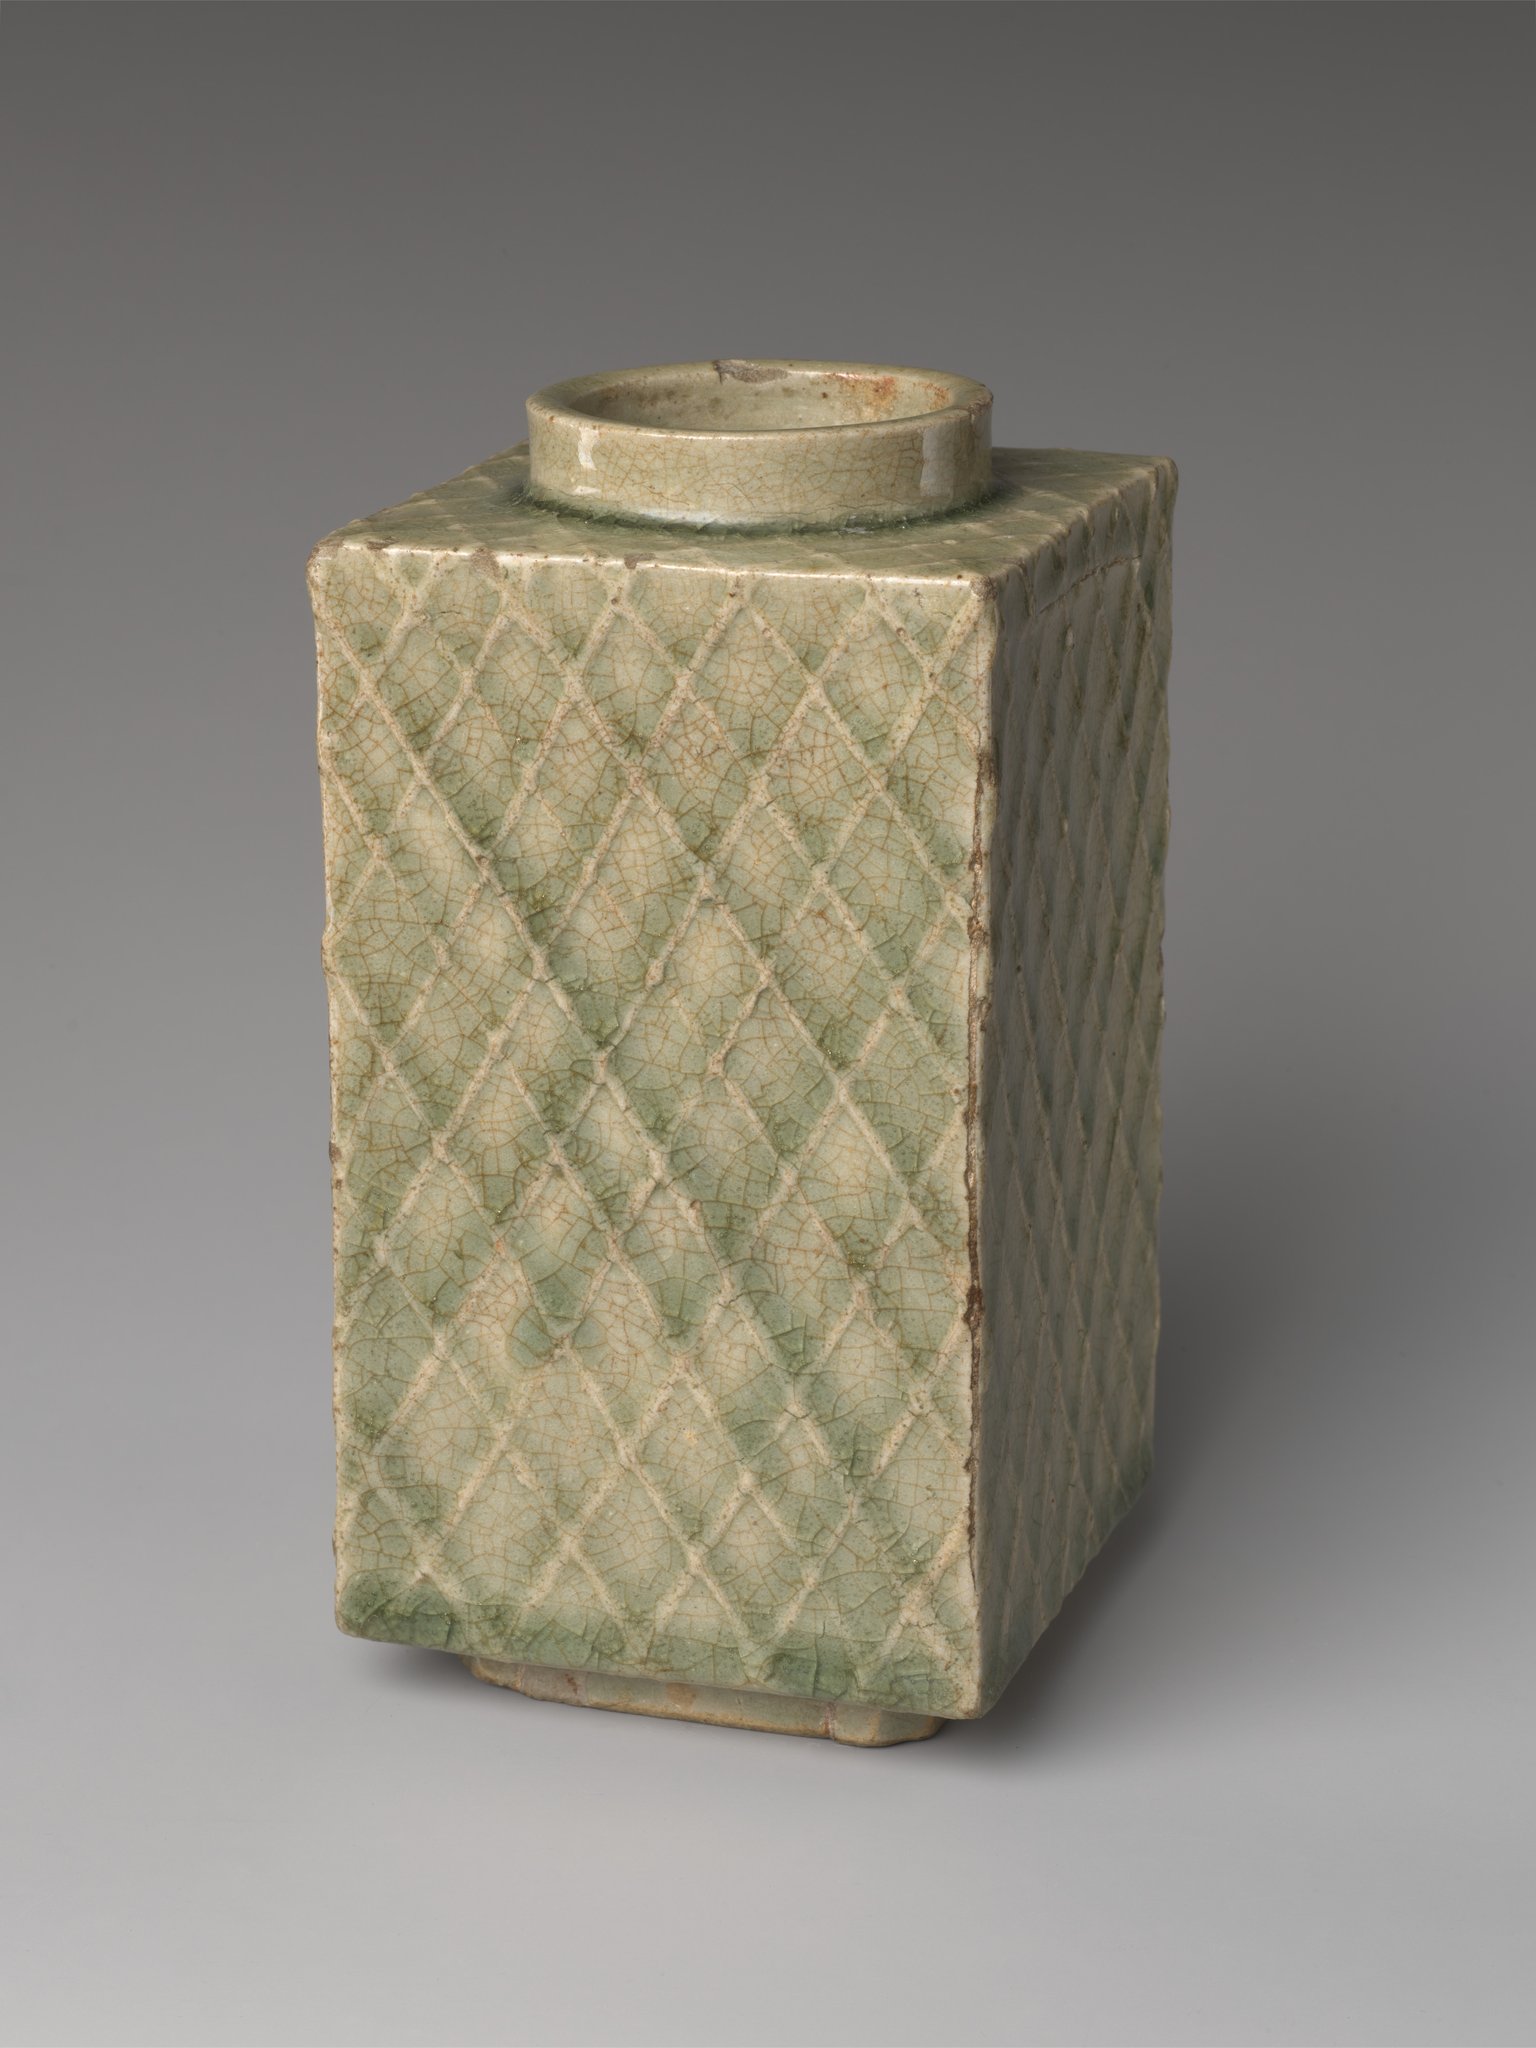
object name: vase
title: Rectangular Vase with Raised Netting Pattern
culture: japanese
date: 1601-1700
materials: copper, glaze, stoneware